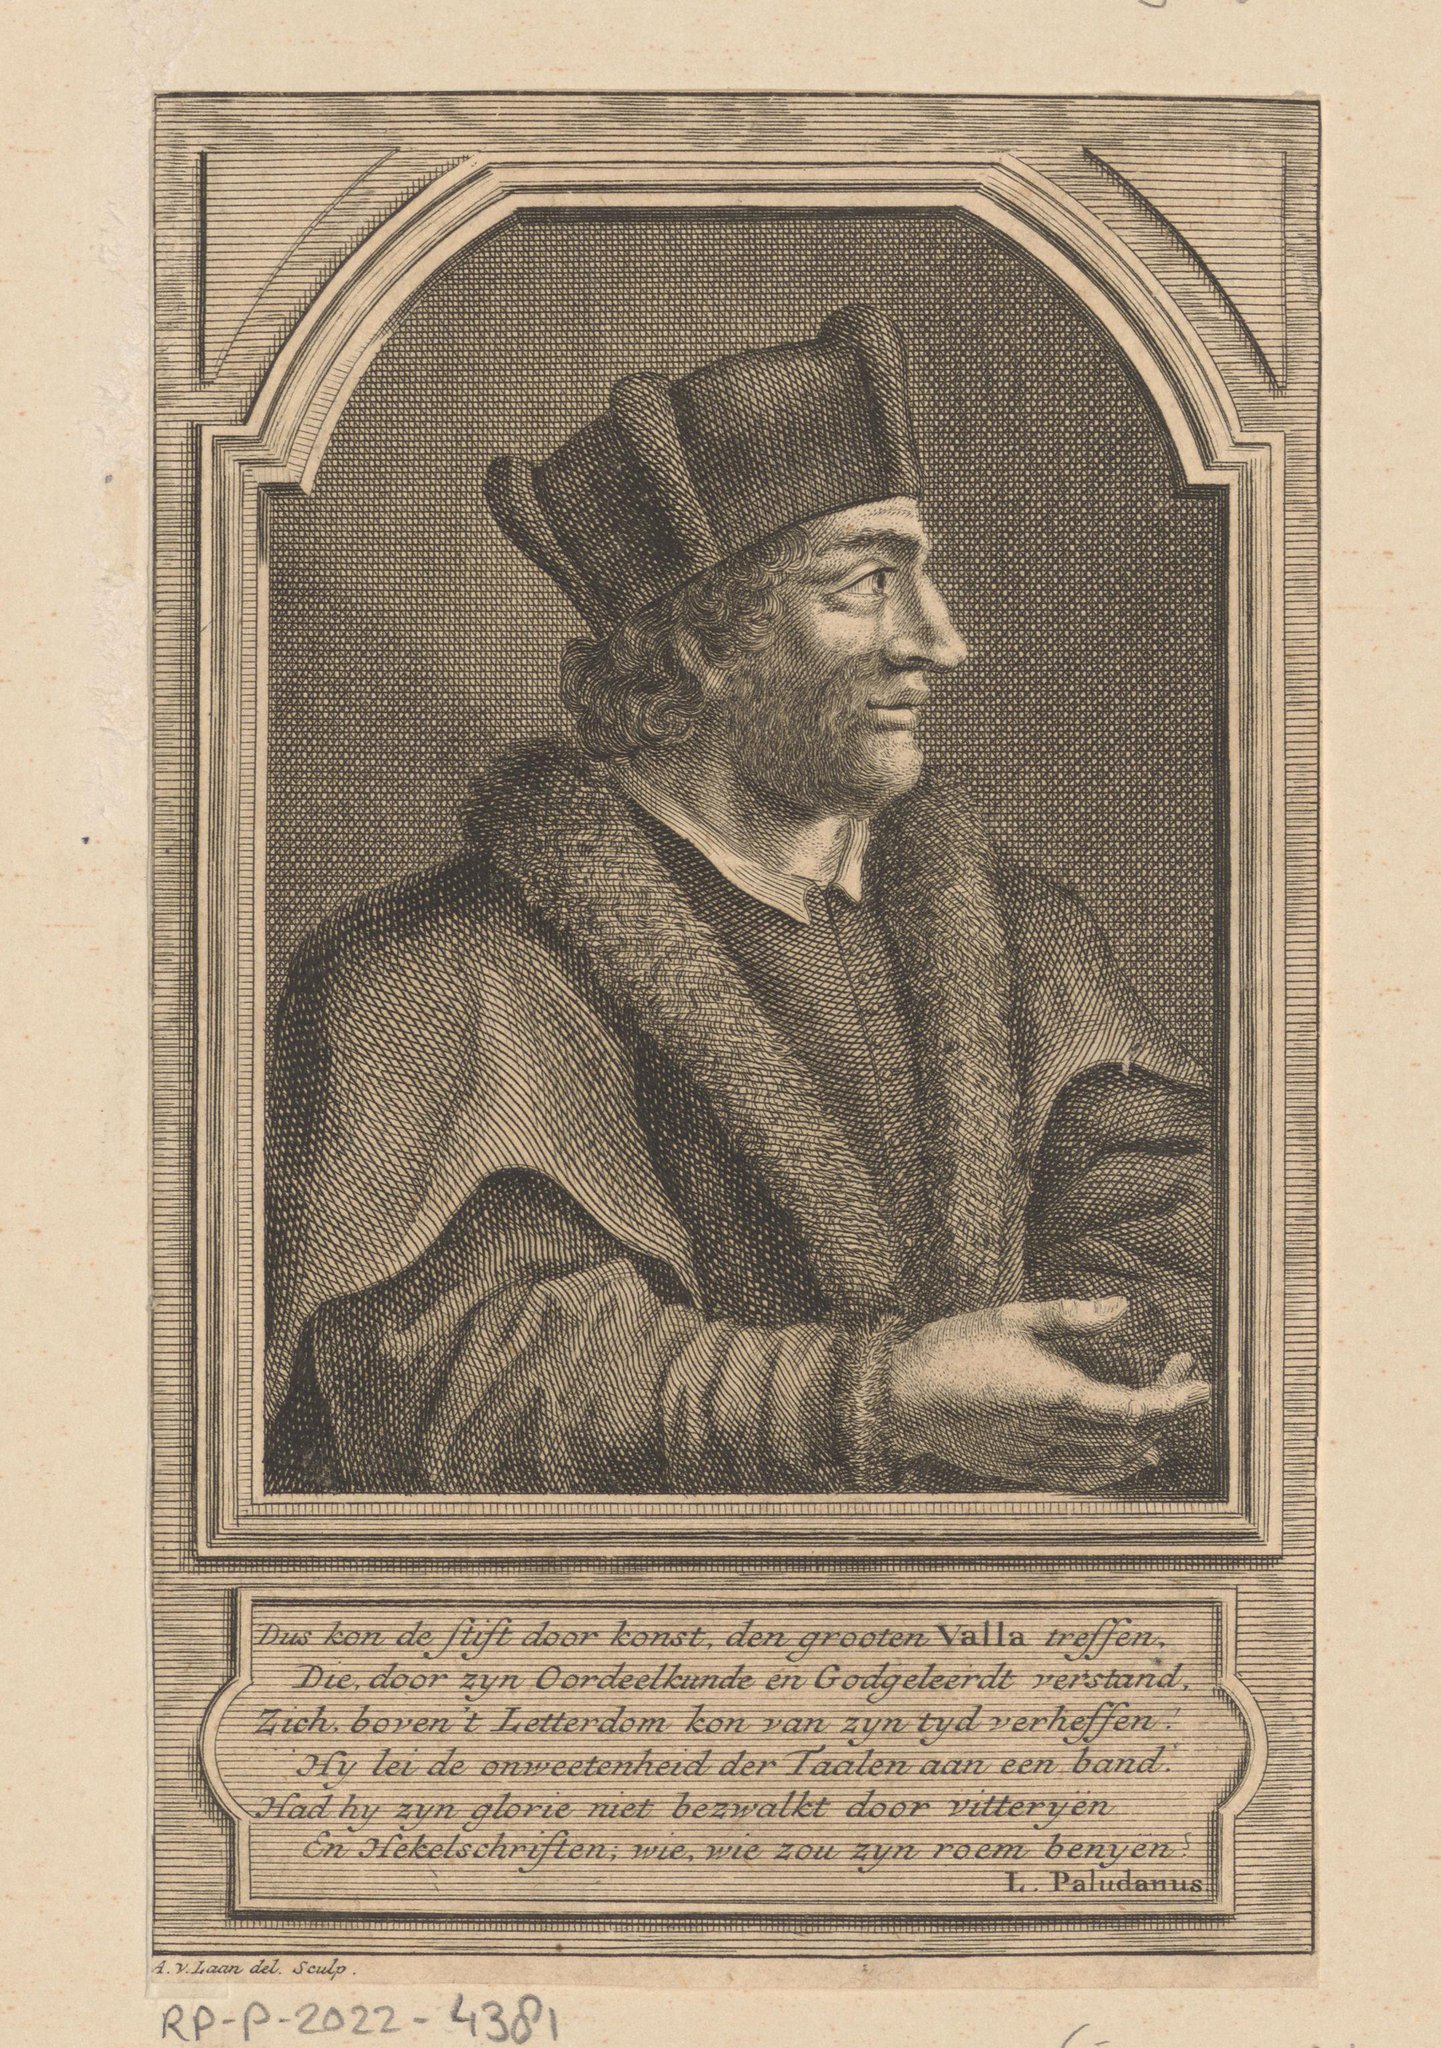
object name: print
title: Portret van Lorenzo Valla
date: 1699-1742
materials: paper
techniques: engraving, etching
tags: scholar, philosopher, historical persons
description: Onder het portret een zesregelig vers in het Nederlands.